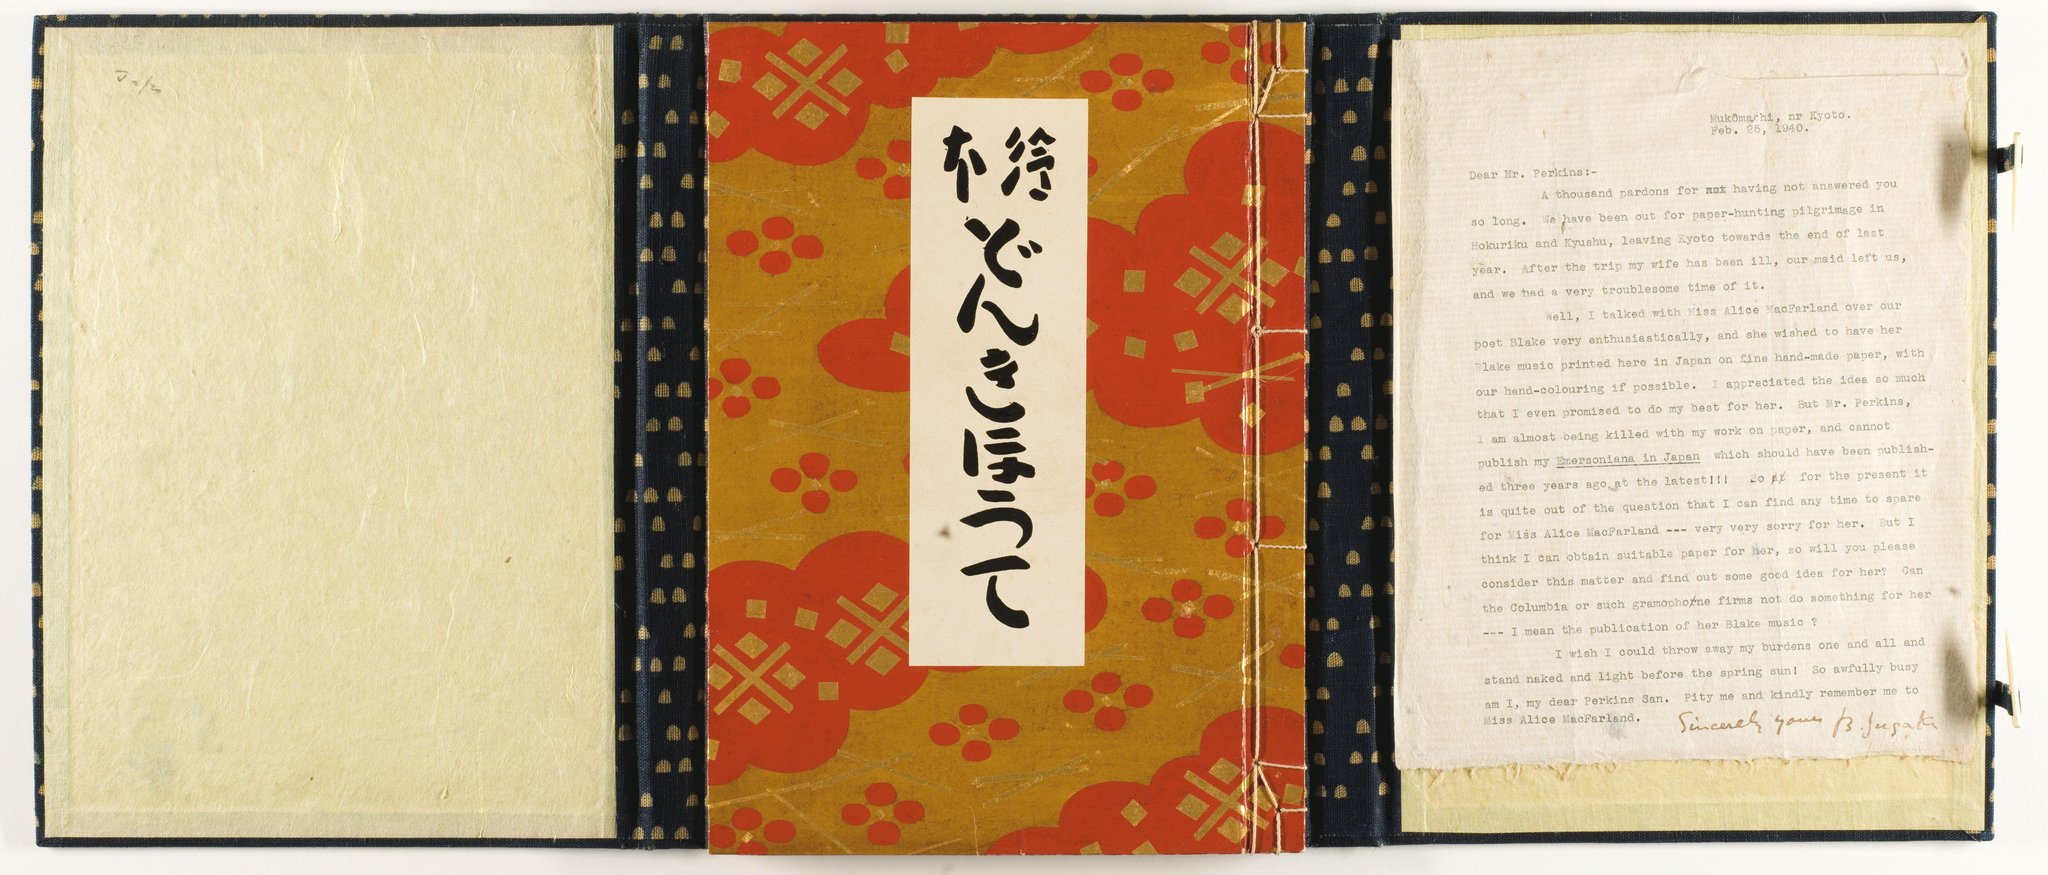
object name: book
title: Don Kihote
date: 1936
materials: paper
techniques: hand coloring, printing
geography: kyoto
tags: don quixote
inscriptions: date